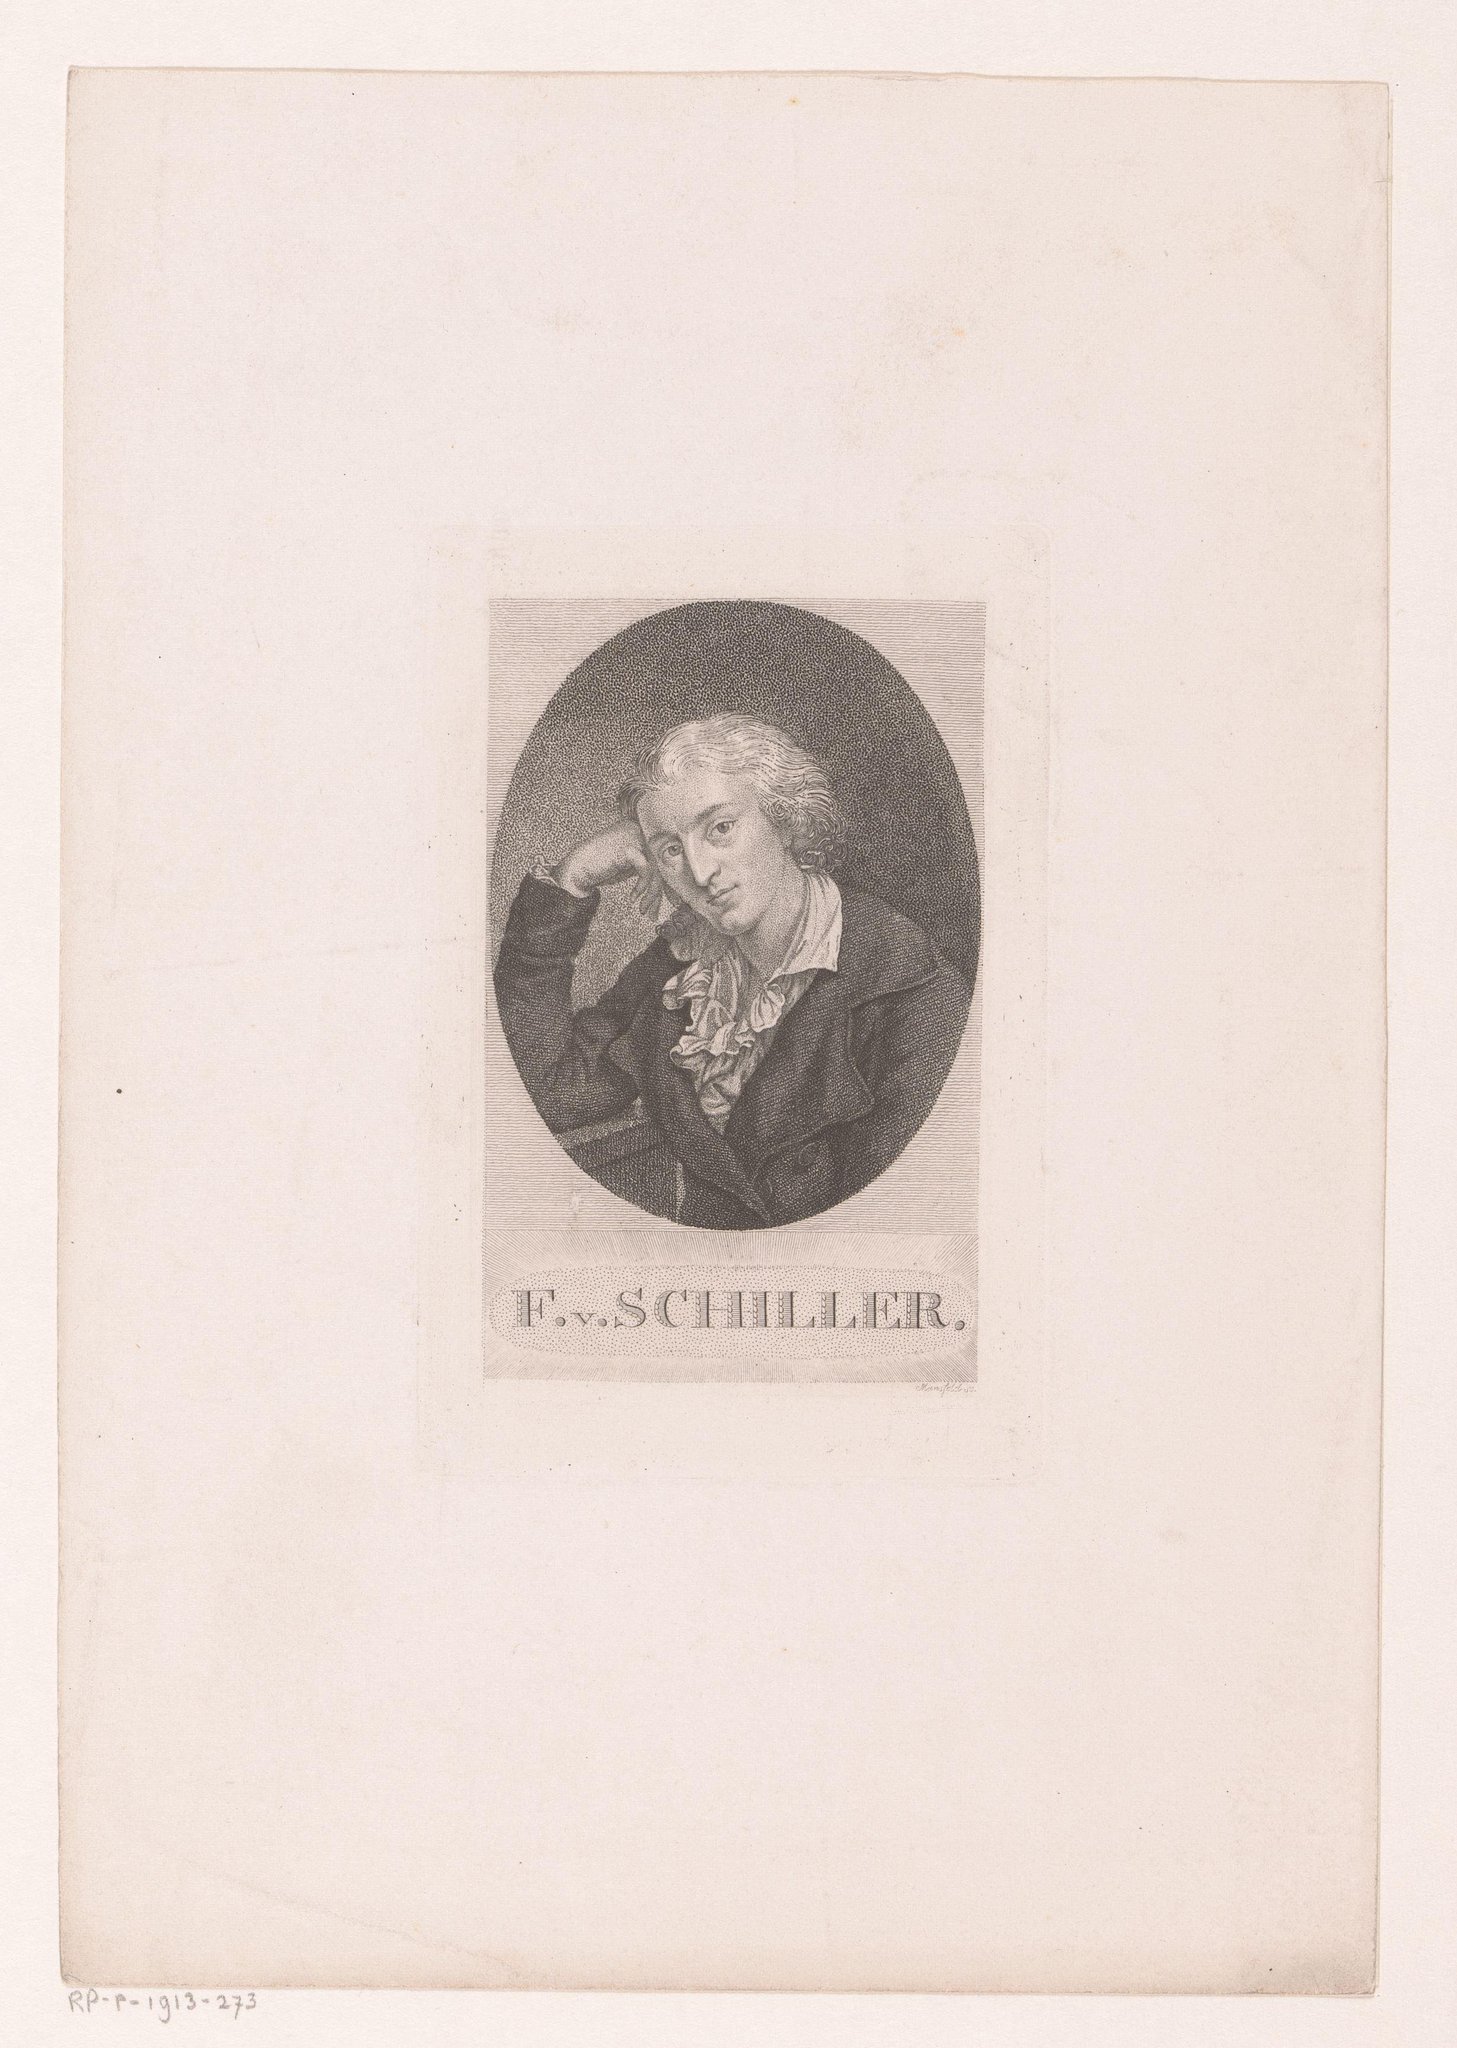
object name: print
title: Portret van Friedrich von Schiller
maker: johann georg mannsfeld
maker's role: print maker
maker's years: 1764-1817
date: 1774-1817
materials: paper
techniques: etching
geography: vienna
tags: friedrich von schiller, historical persons, head held in the hand(s), with elbows leaning on an elevation or on the knees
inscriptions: collector's mark: Lugt 2228